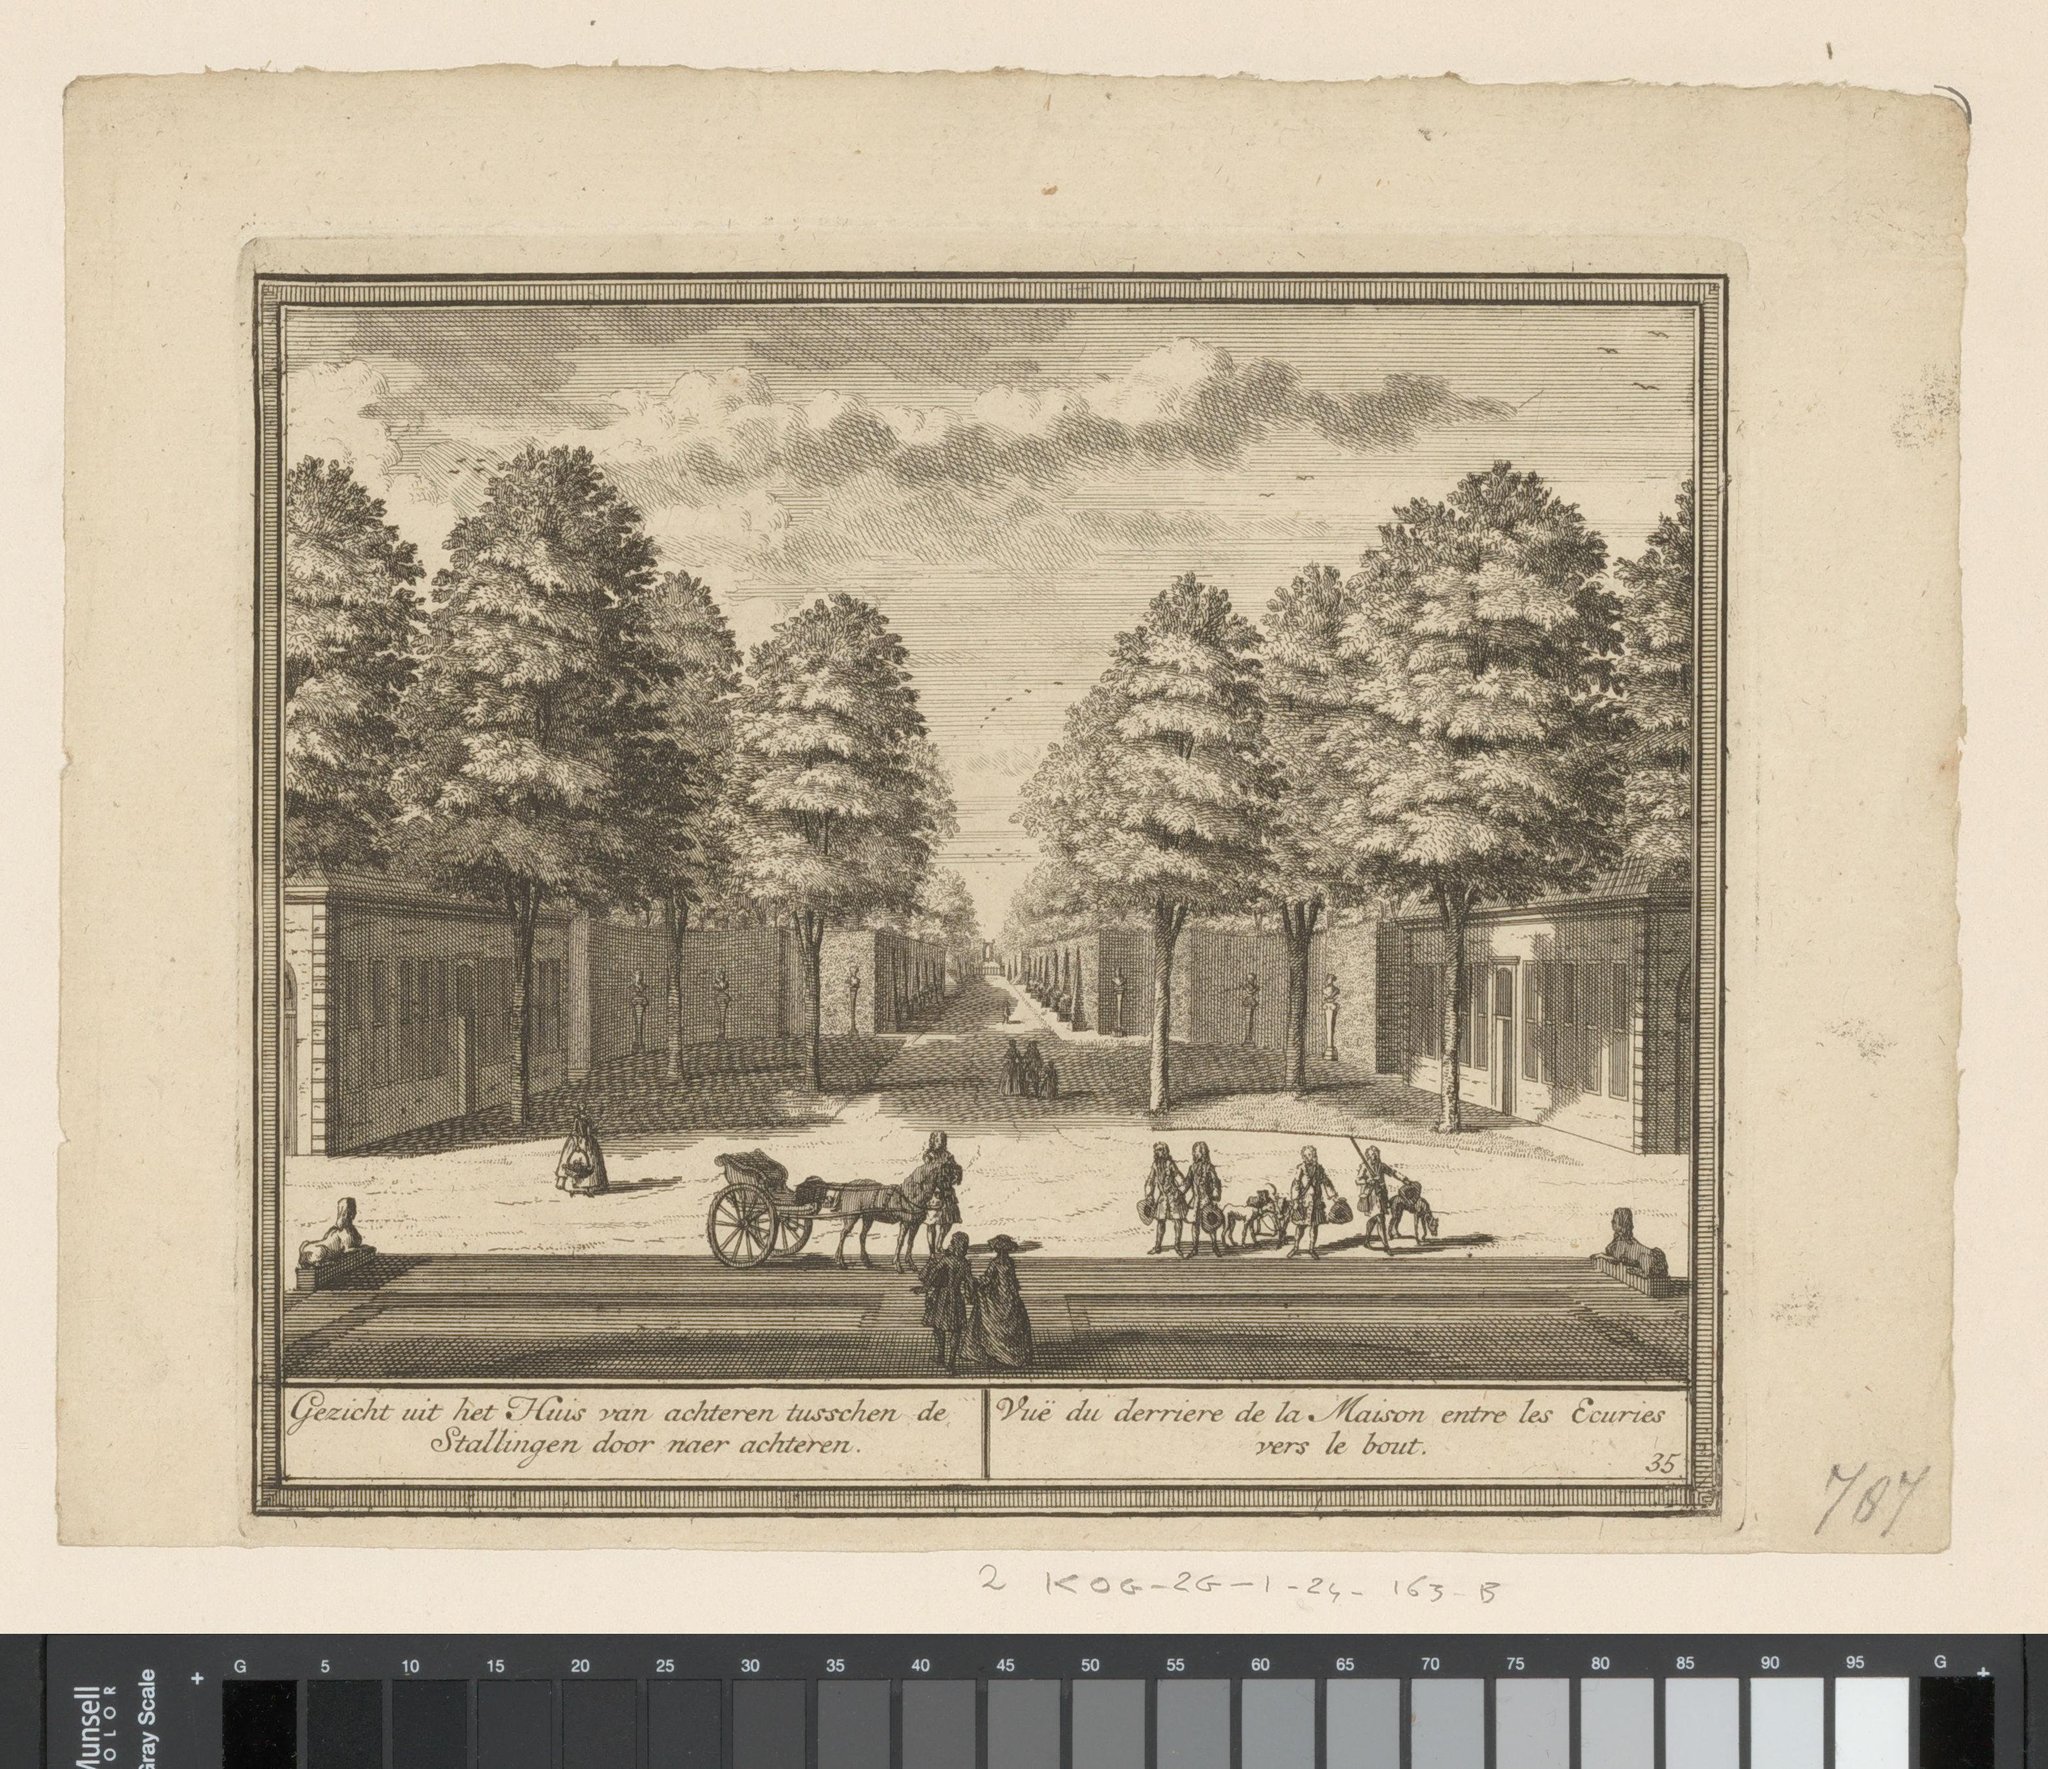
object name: print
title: Gezicht uit het Huis van achteren tusschen de Stallingen door naer achteren / Vuë du derriere de la Maison entre les Ecuries vers le bout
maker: hendrik de leth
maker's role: draughtsman, print maker, publisher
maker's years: 1703-1766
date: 1729-1732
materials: paper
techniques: engraving, etching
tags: french or architectonic garden; formal garden, stall, stable, country-house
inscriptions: stamp, stamp, collector's mark: Lugt 1641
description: Prent mogelijk uit: Brouërius van Nidek, Matthaeus. Het zegepralend Kennemerland, vertoond in 100 heerlyke gezichten. Amsterdam: Jan Roman, s.a. Of uit: Brouërius van Nidek, Matthaeus. Het zegepralend Kennemerland, vertoond in veele heerlyke gezichten. Amsterdam: Andries en Hendrik de Leth, s.a [1729-1732].